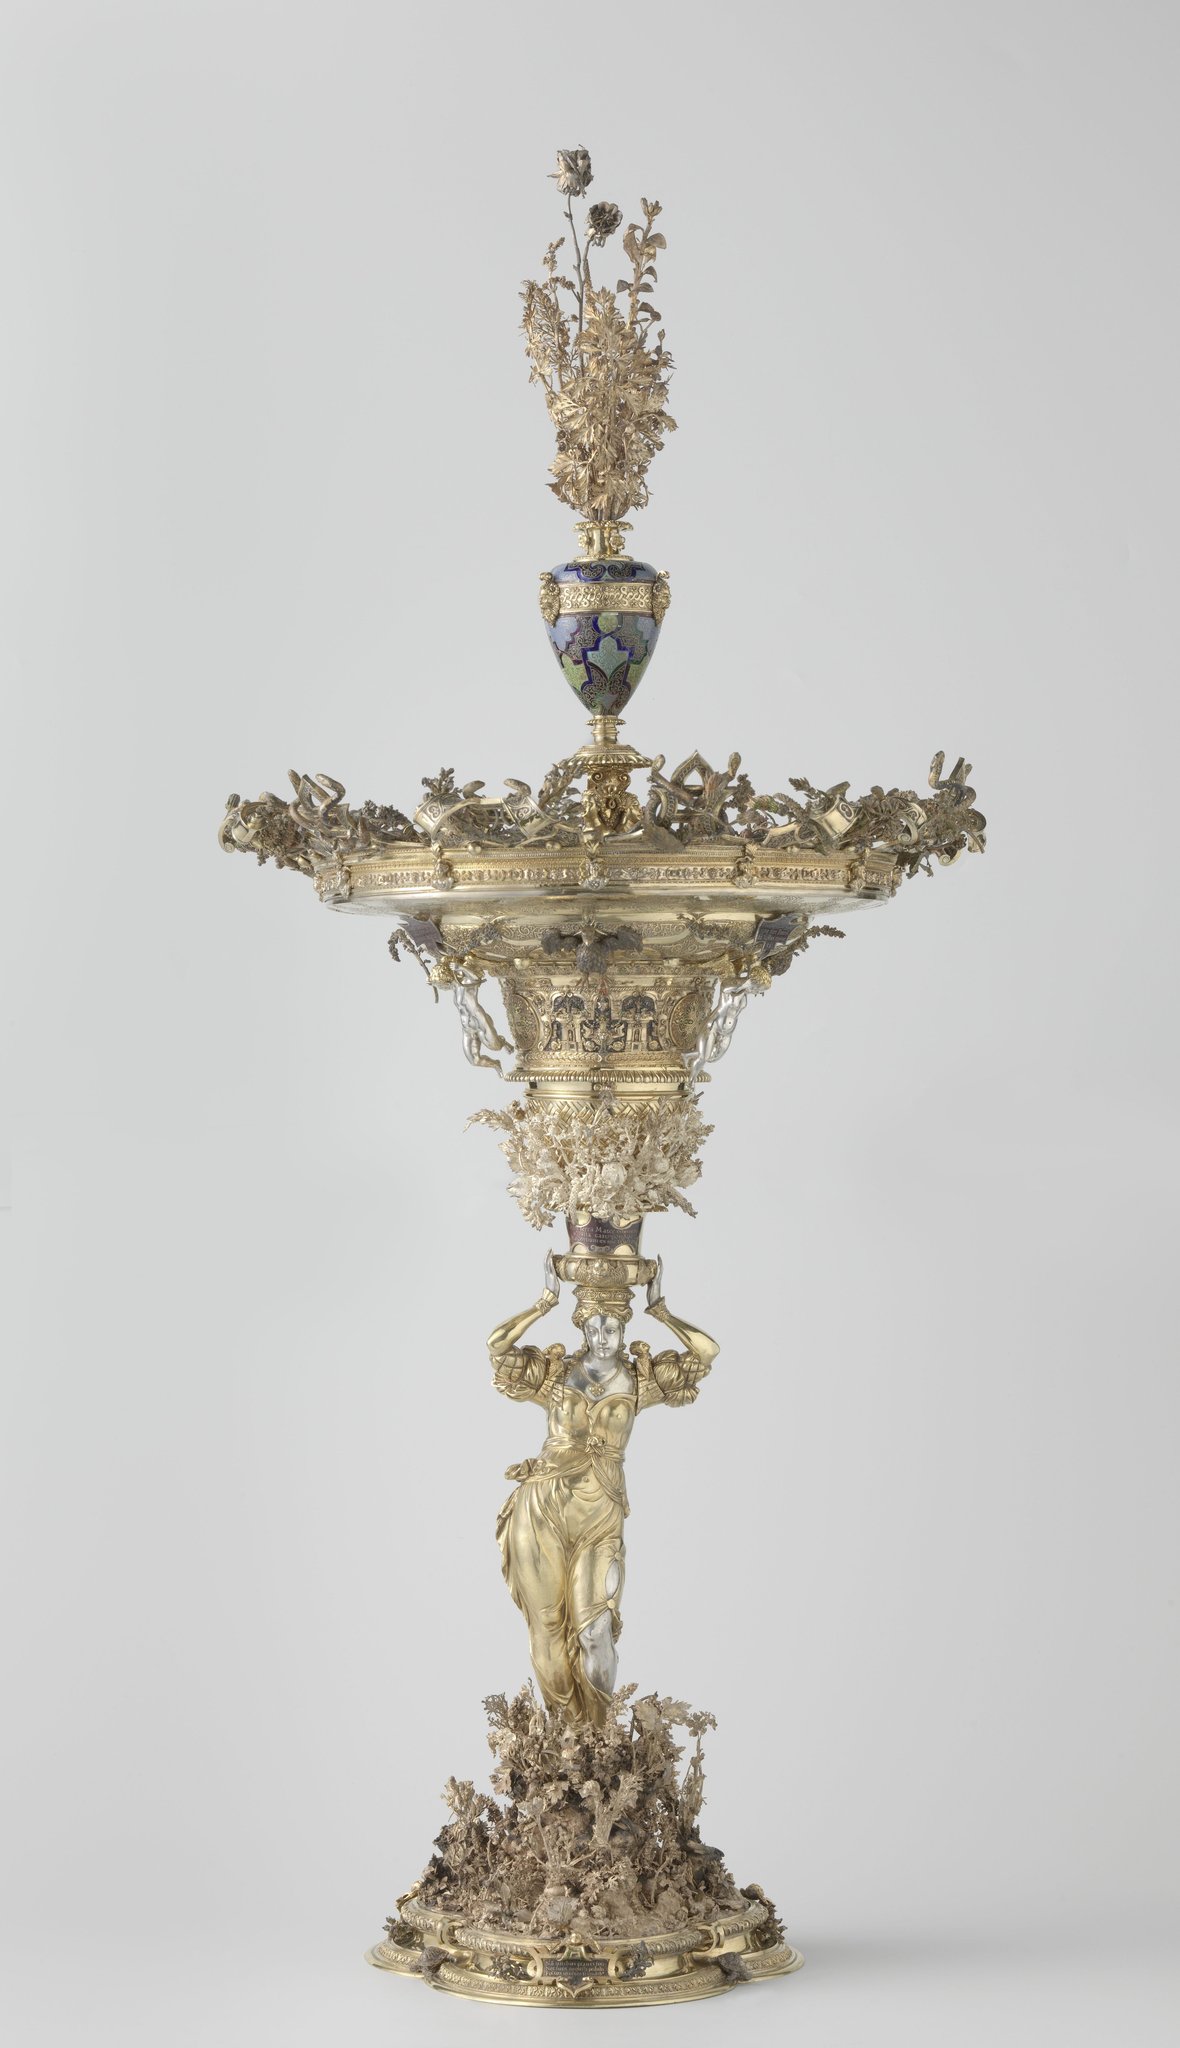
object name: table piece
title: Table ornament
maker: wenzel jamnitzer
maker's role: print maker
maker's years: 1508-1585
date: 1549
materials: silver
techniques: casting, etching, gilding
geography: nuremberg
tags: tortoises, turtles, (story of) cybele, rhea cybele, great mother of the gods (berecynt(h)ia), earth (one of the four elements), lizards: lizard, flowers in a vase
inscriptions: town mark: ‘N’, maker's mark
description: This table ornament is an ode to the Earth and all that it brings forth, as well as an unsurpassed display of artistic and technical skill. The stem of the dish represents Mother Earth. She is surrounded by flowers, herbs and small animals – all cast from specimens collected in the wild. The lives of actual animals were sacrificed to model the young grass snakes and lizards.